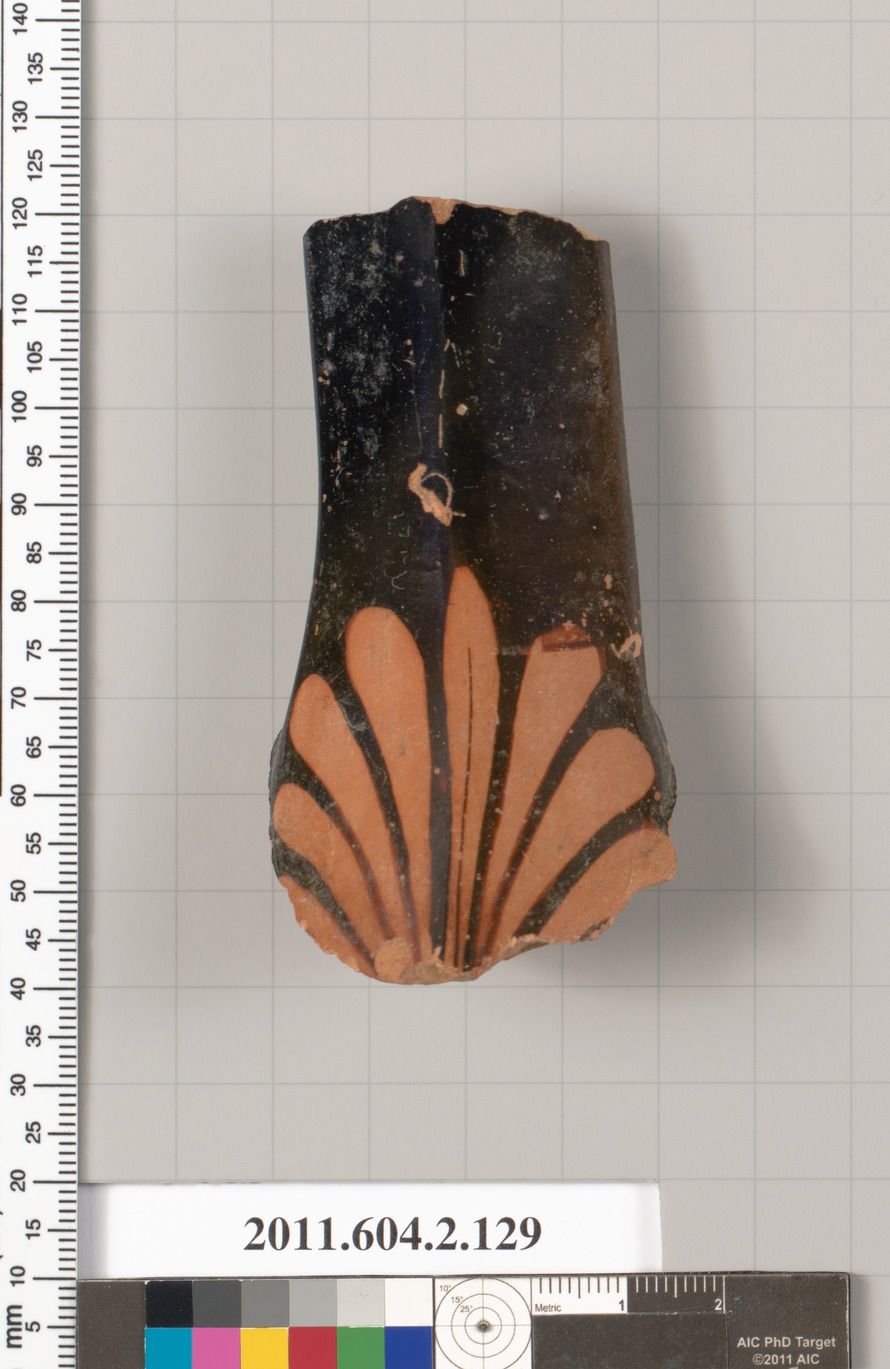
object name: pelike fragment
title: Terracotta fragment of a pelike (jar)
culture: greek, attic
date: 510-480 BCE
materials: terracotta